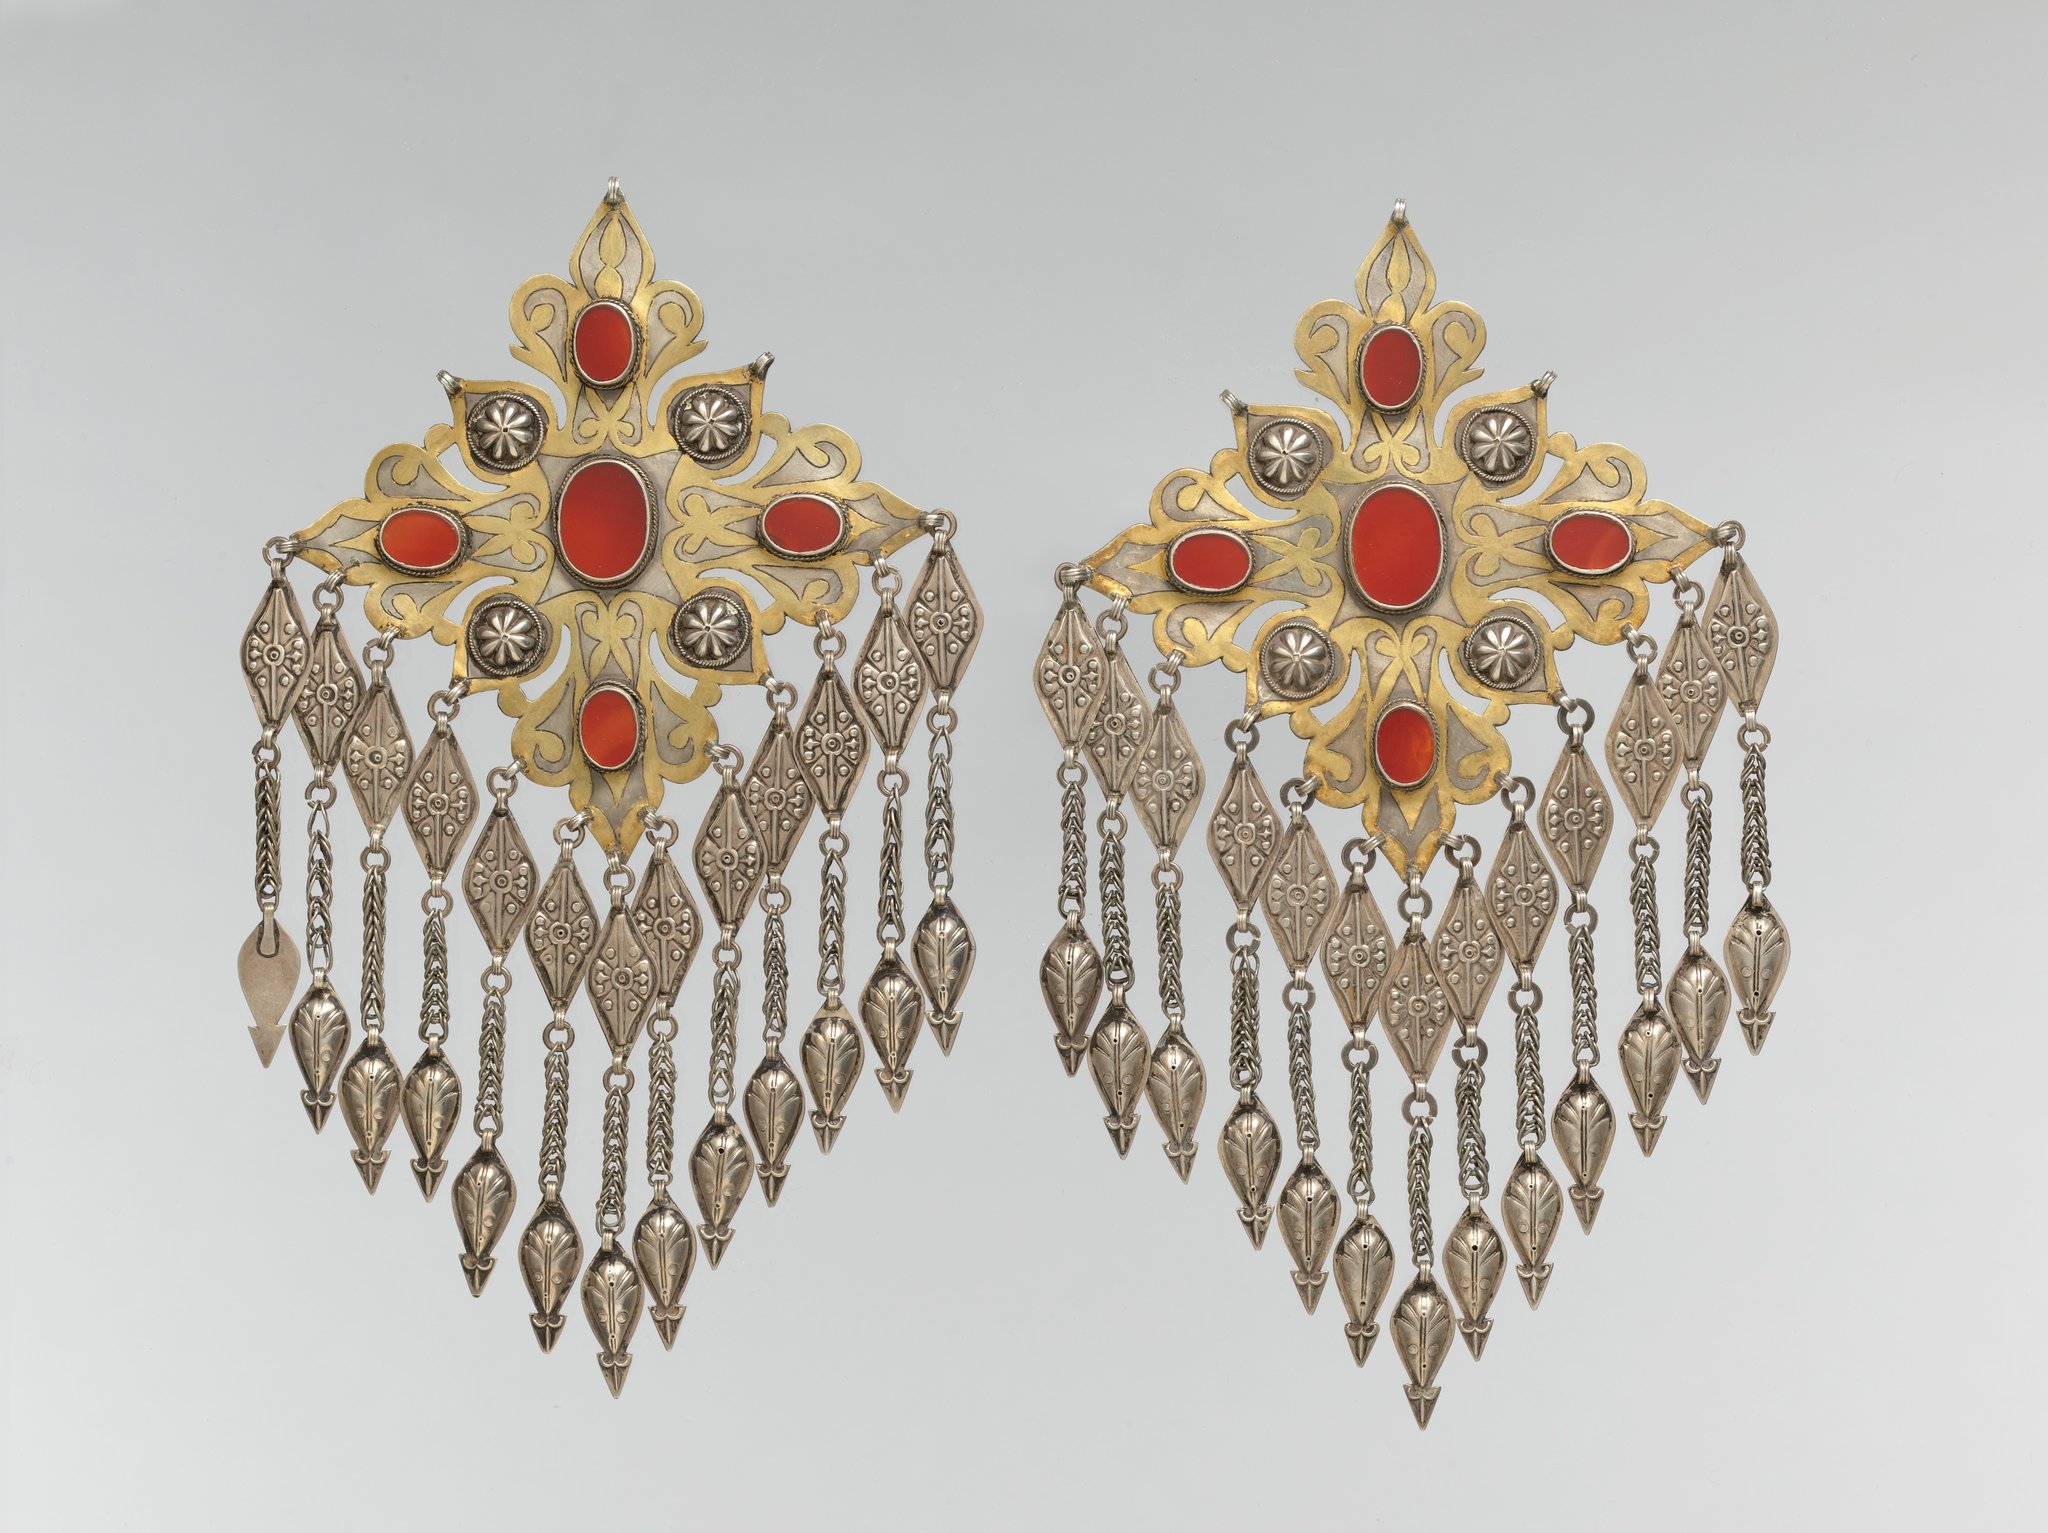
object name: ornament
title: Teke Floral Pectoral Ornament, One of a Pair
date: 1867-1933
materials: carnelian, silver, metal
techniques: chasing, cutting, gilding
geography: central asia